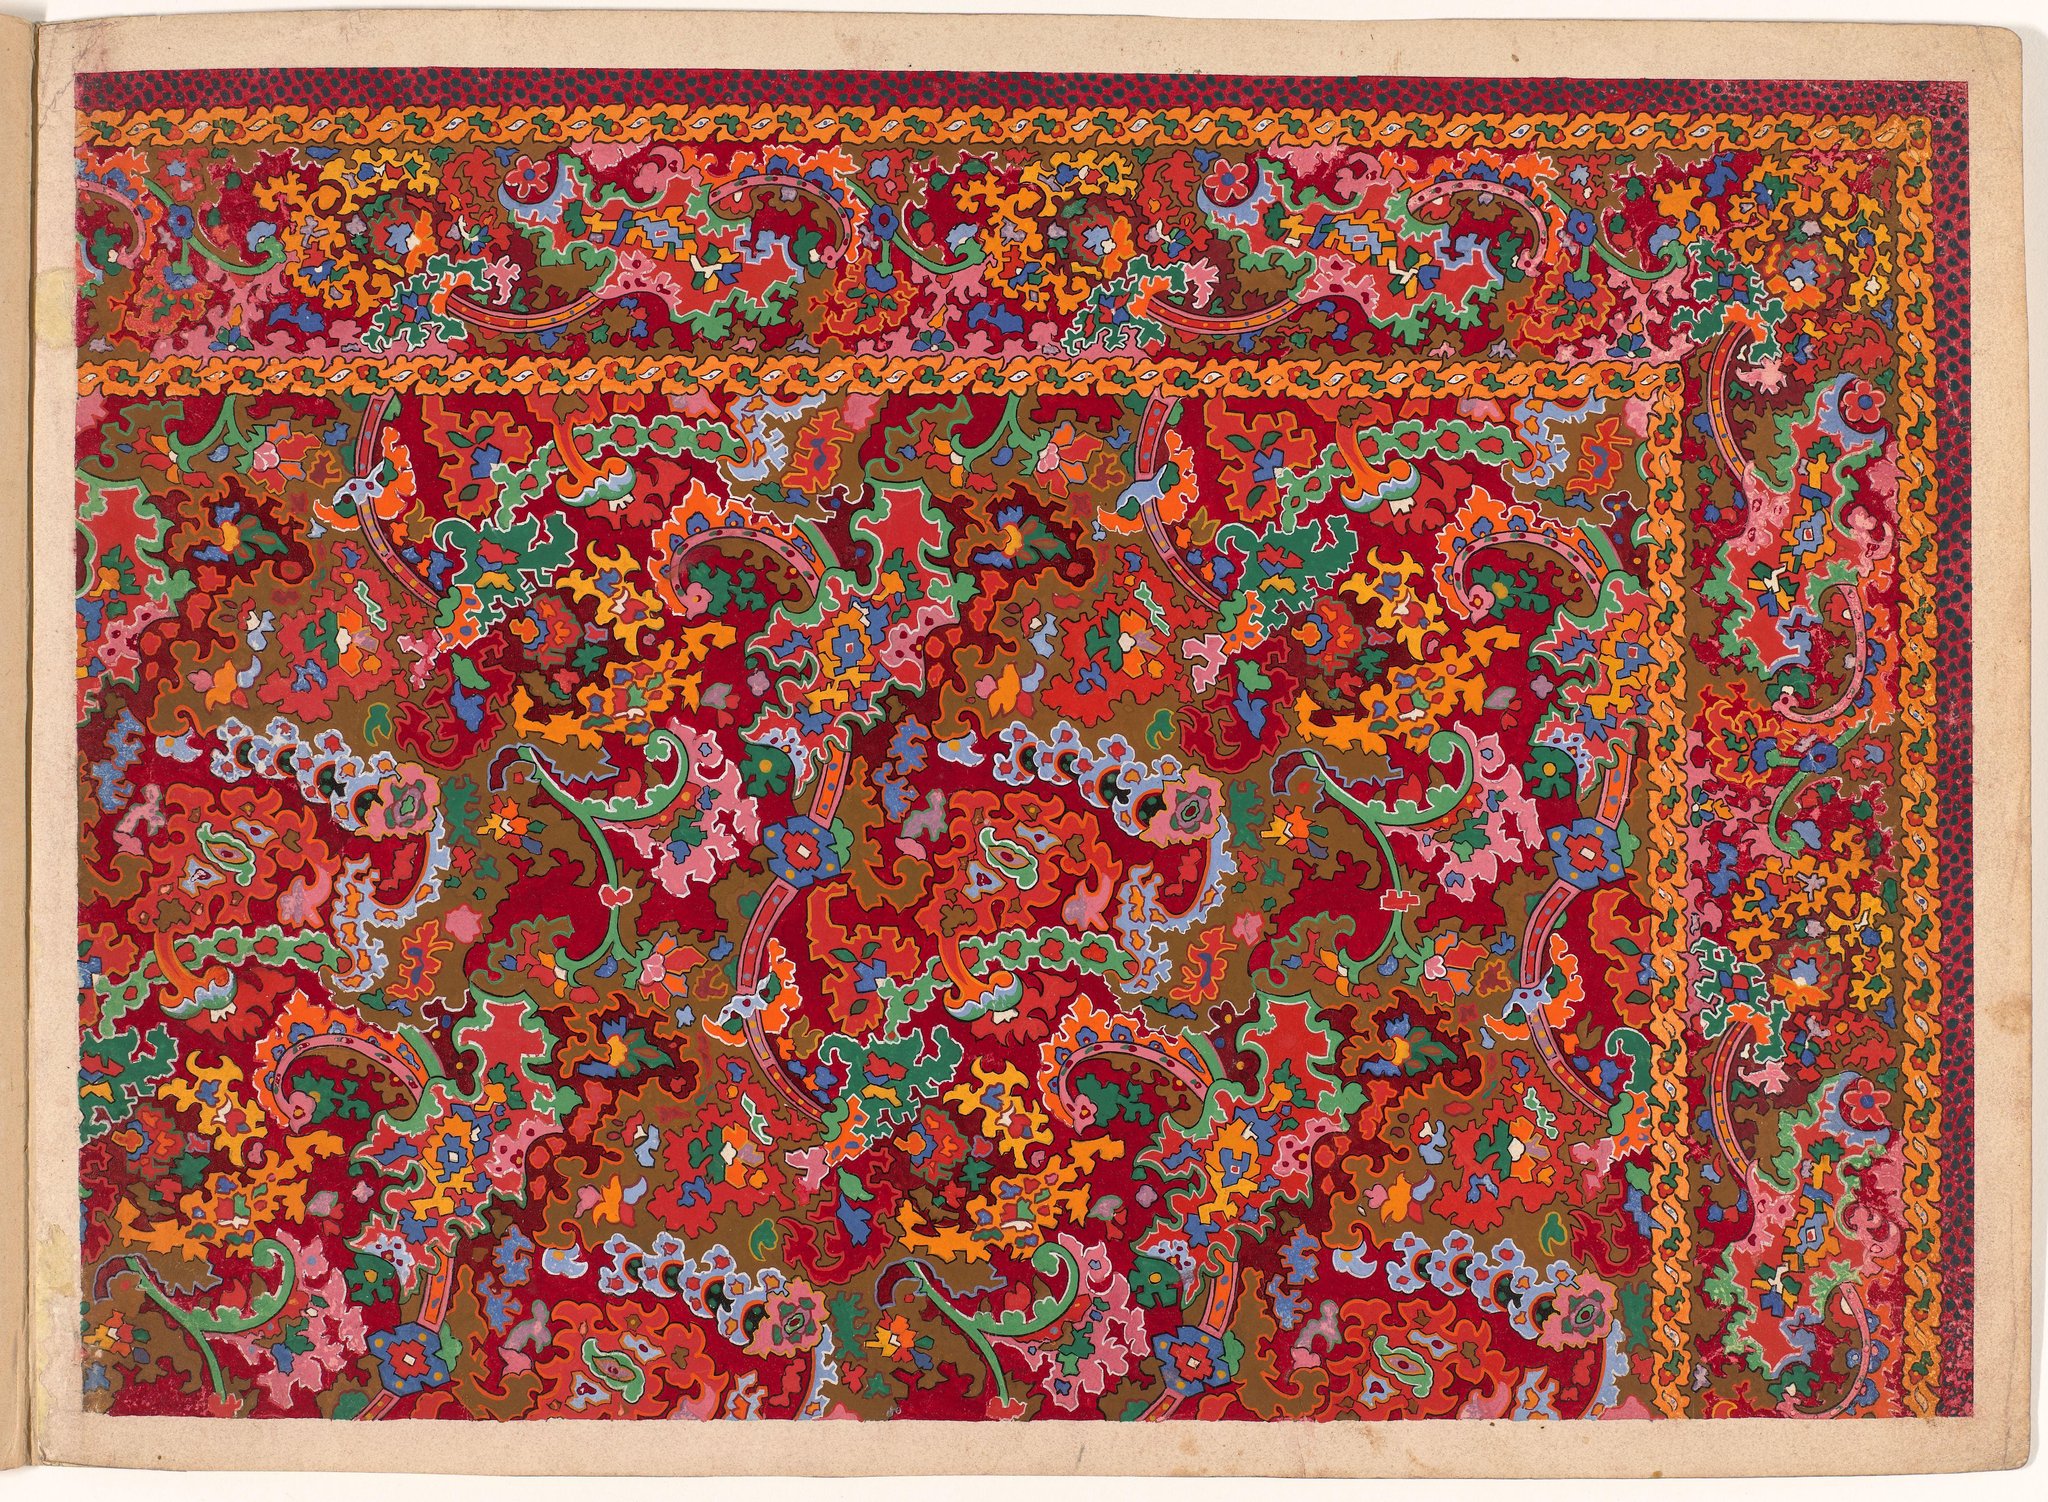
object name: drawing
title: Ontwerp voor een tapijt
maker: Anonymous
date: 1851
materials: gouache, paper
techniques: brush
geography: amsterdam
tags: ornaments ~ art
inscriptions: retailer's mark: ‘JHS.’, number: ‘No 361.’, inscription: ‘von el[...]’, inscription: ‘Kan alleen in 1. qualiteit, extra kleuren gemaakt worden. Prijs per vierk. oude [...]l’, inscription: ‘in 1851 aan den Heer de Kat’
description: De presentatietekeningen BK-1971-77-1 t/m 86 zijn kopieën van de originele ontwerptekeningen. Ze werden gemaakt voor vertegenwoordigers van bijvoorbeeld magazijnen, die ze aan hun klanten konden tonen. De meeste tekeningen tonen een kwart van het dessin inclusief rand, middenpartij (de zogenaamde grond of fond) en centraal medaillon. Door het gebruik van spiegels kan de illusie van het gehele tapijt worden opgeroepen. Een deel van de tekeningen heeft een alfabetische opeenvolgende letter als kenmerk, de andere groep een cijfer.Waarschijnlijk is de reeks dessins met een letter eerder samengesteld dan de genummerde tekeningen.